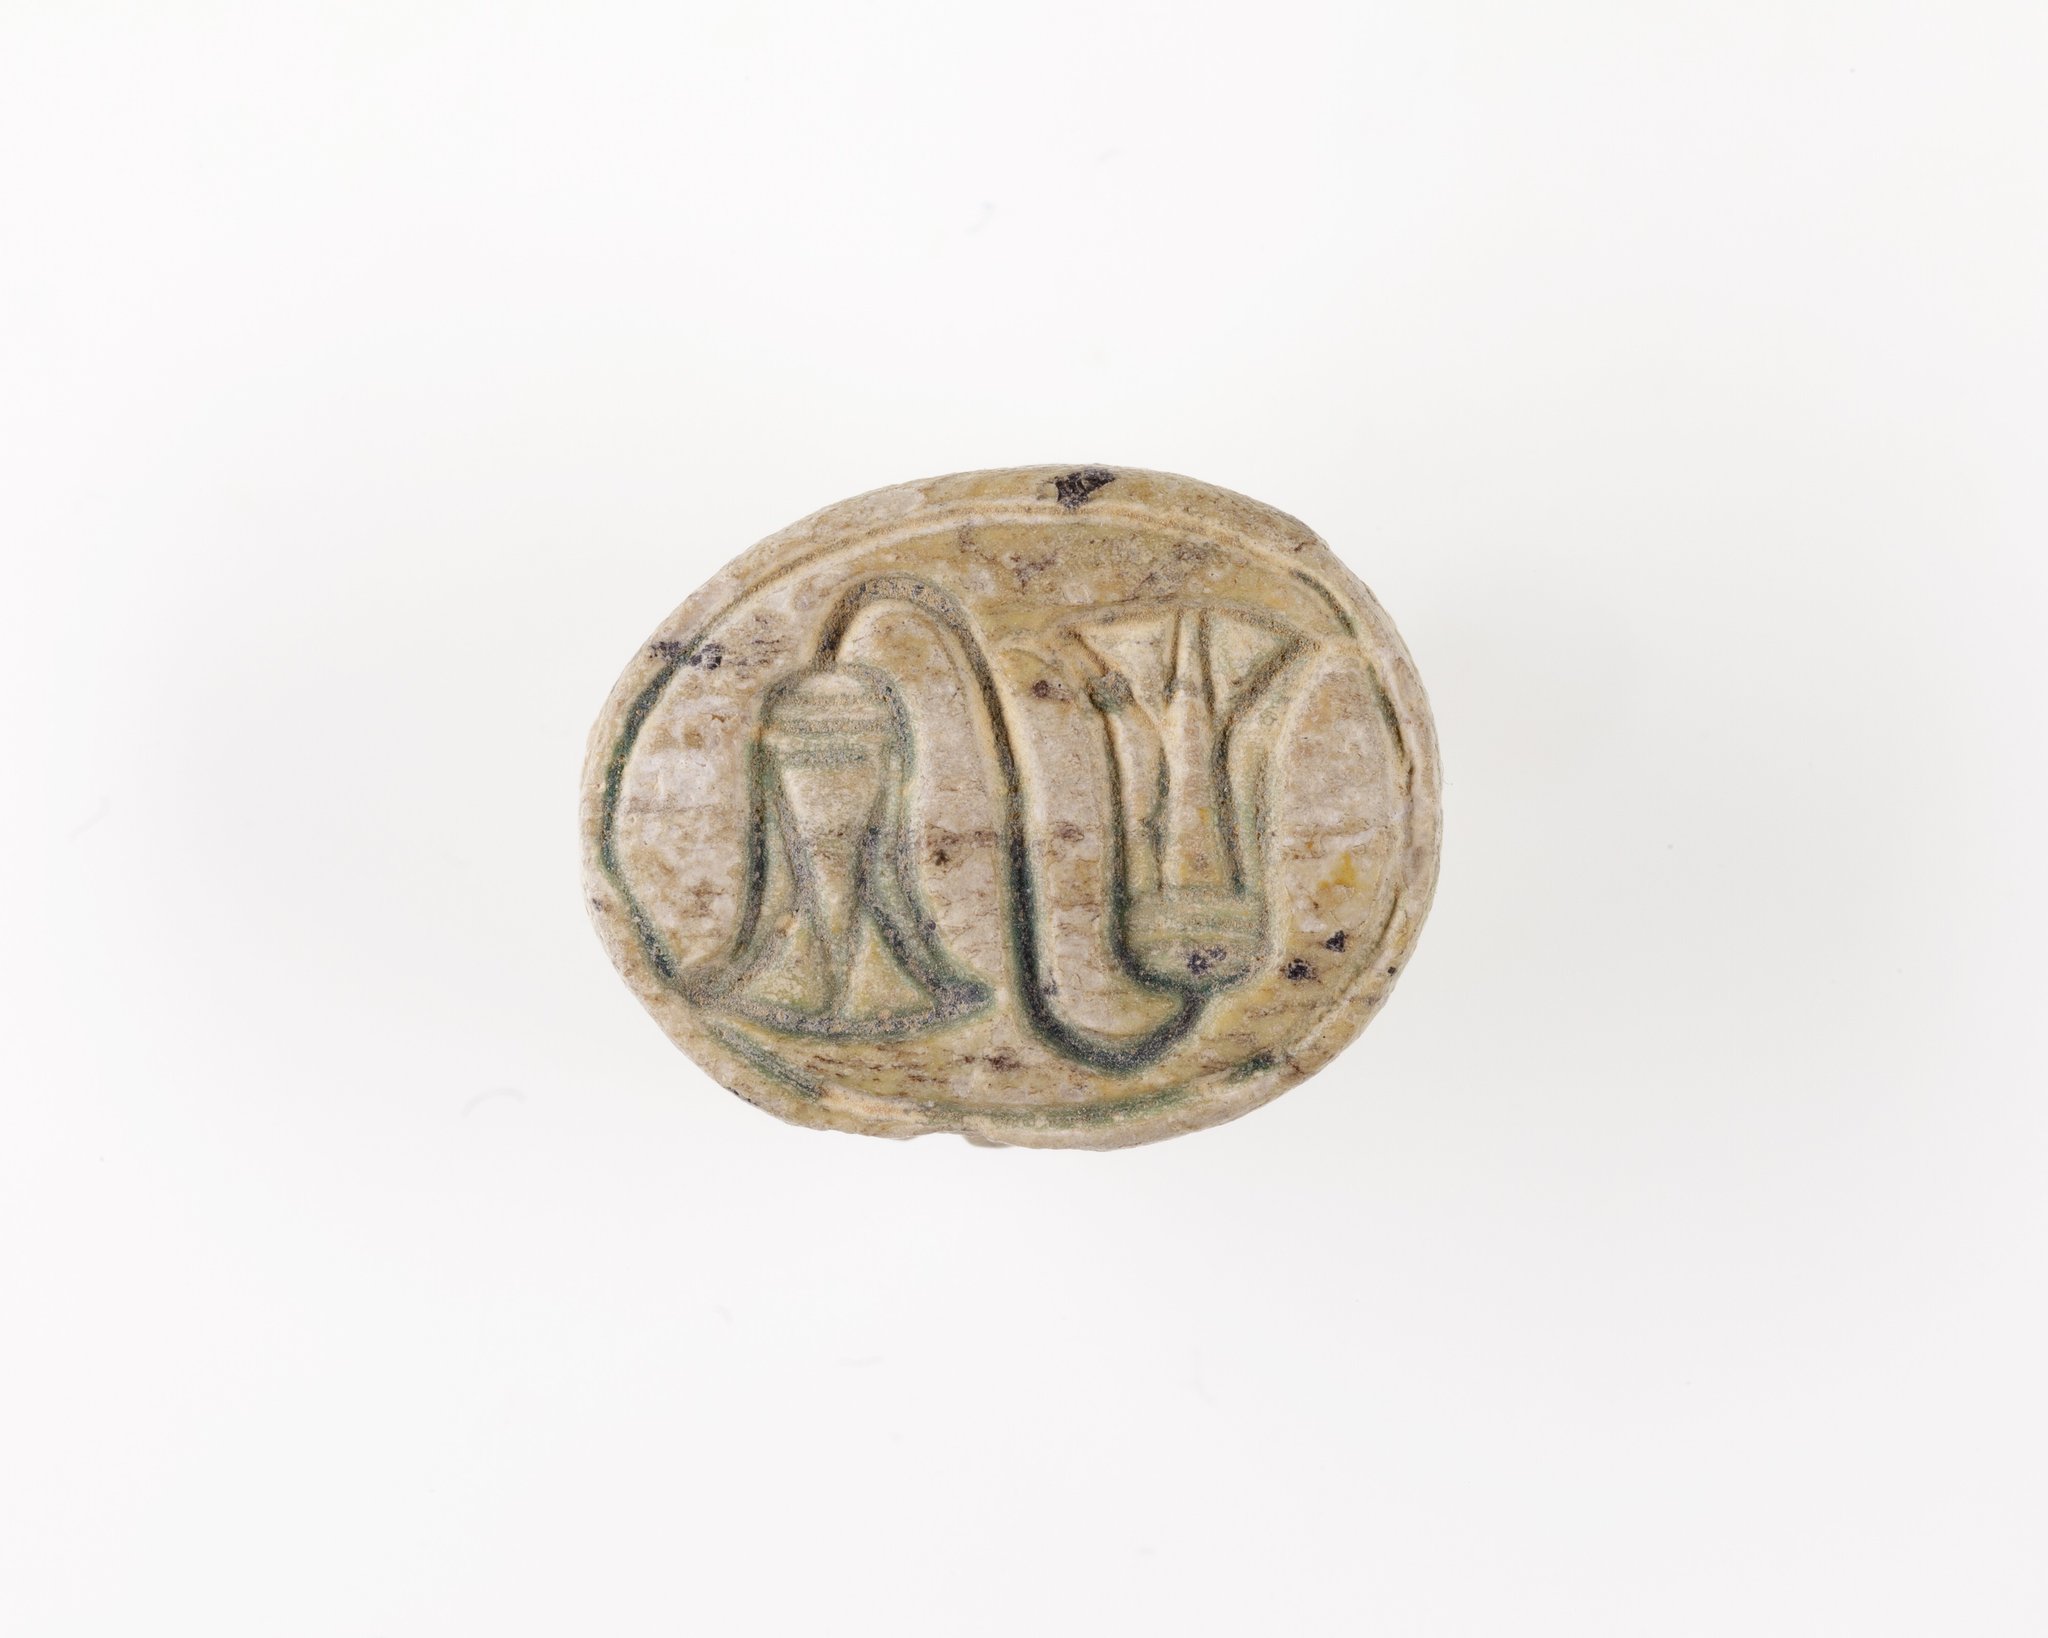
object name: scarab, lotus flower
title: Scarab with Lotus Decoration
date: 1550-1458 BCE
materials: stone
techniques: glazing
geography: egypt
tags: scarabs